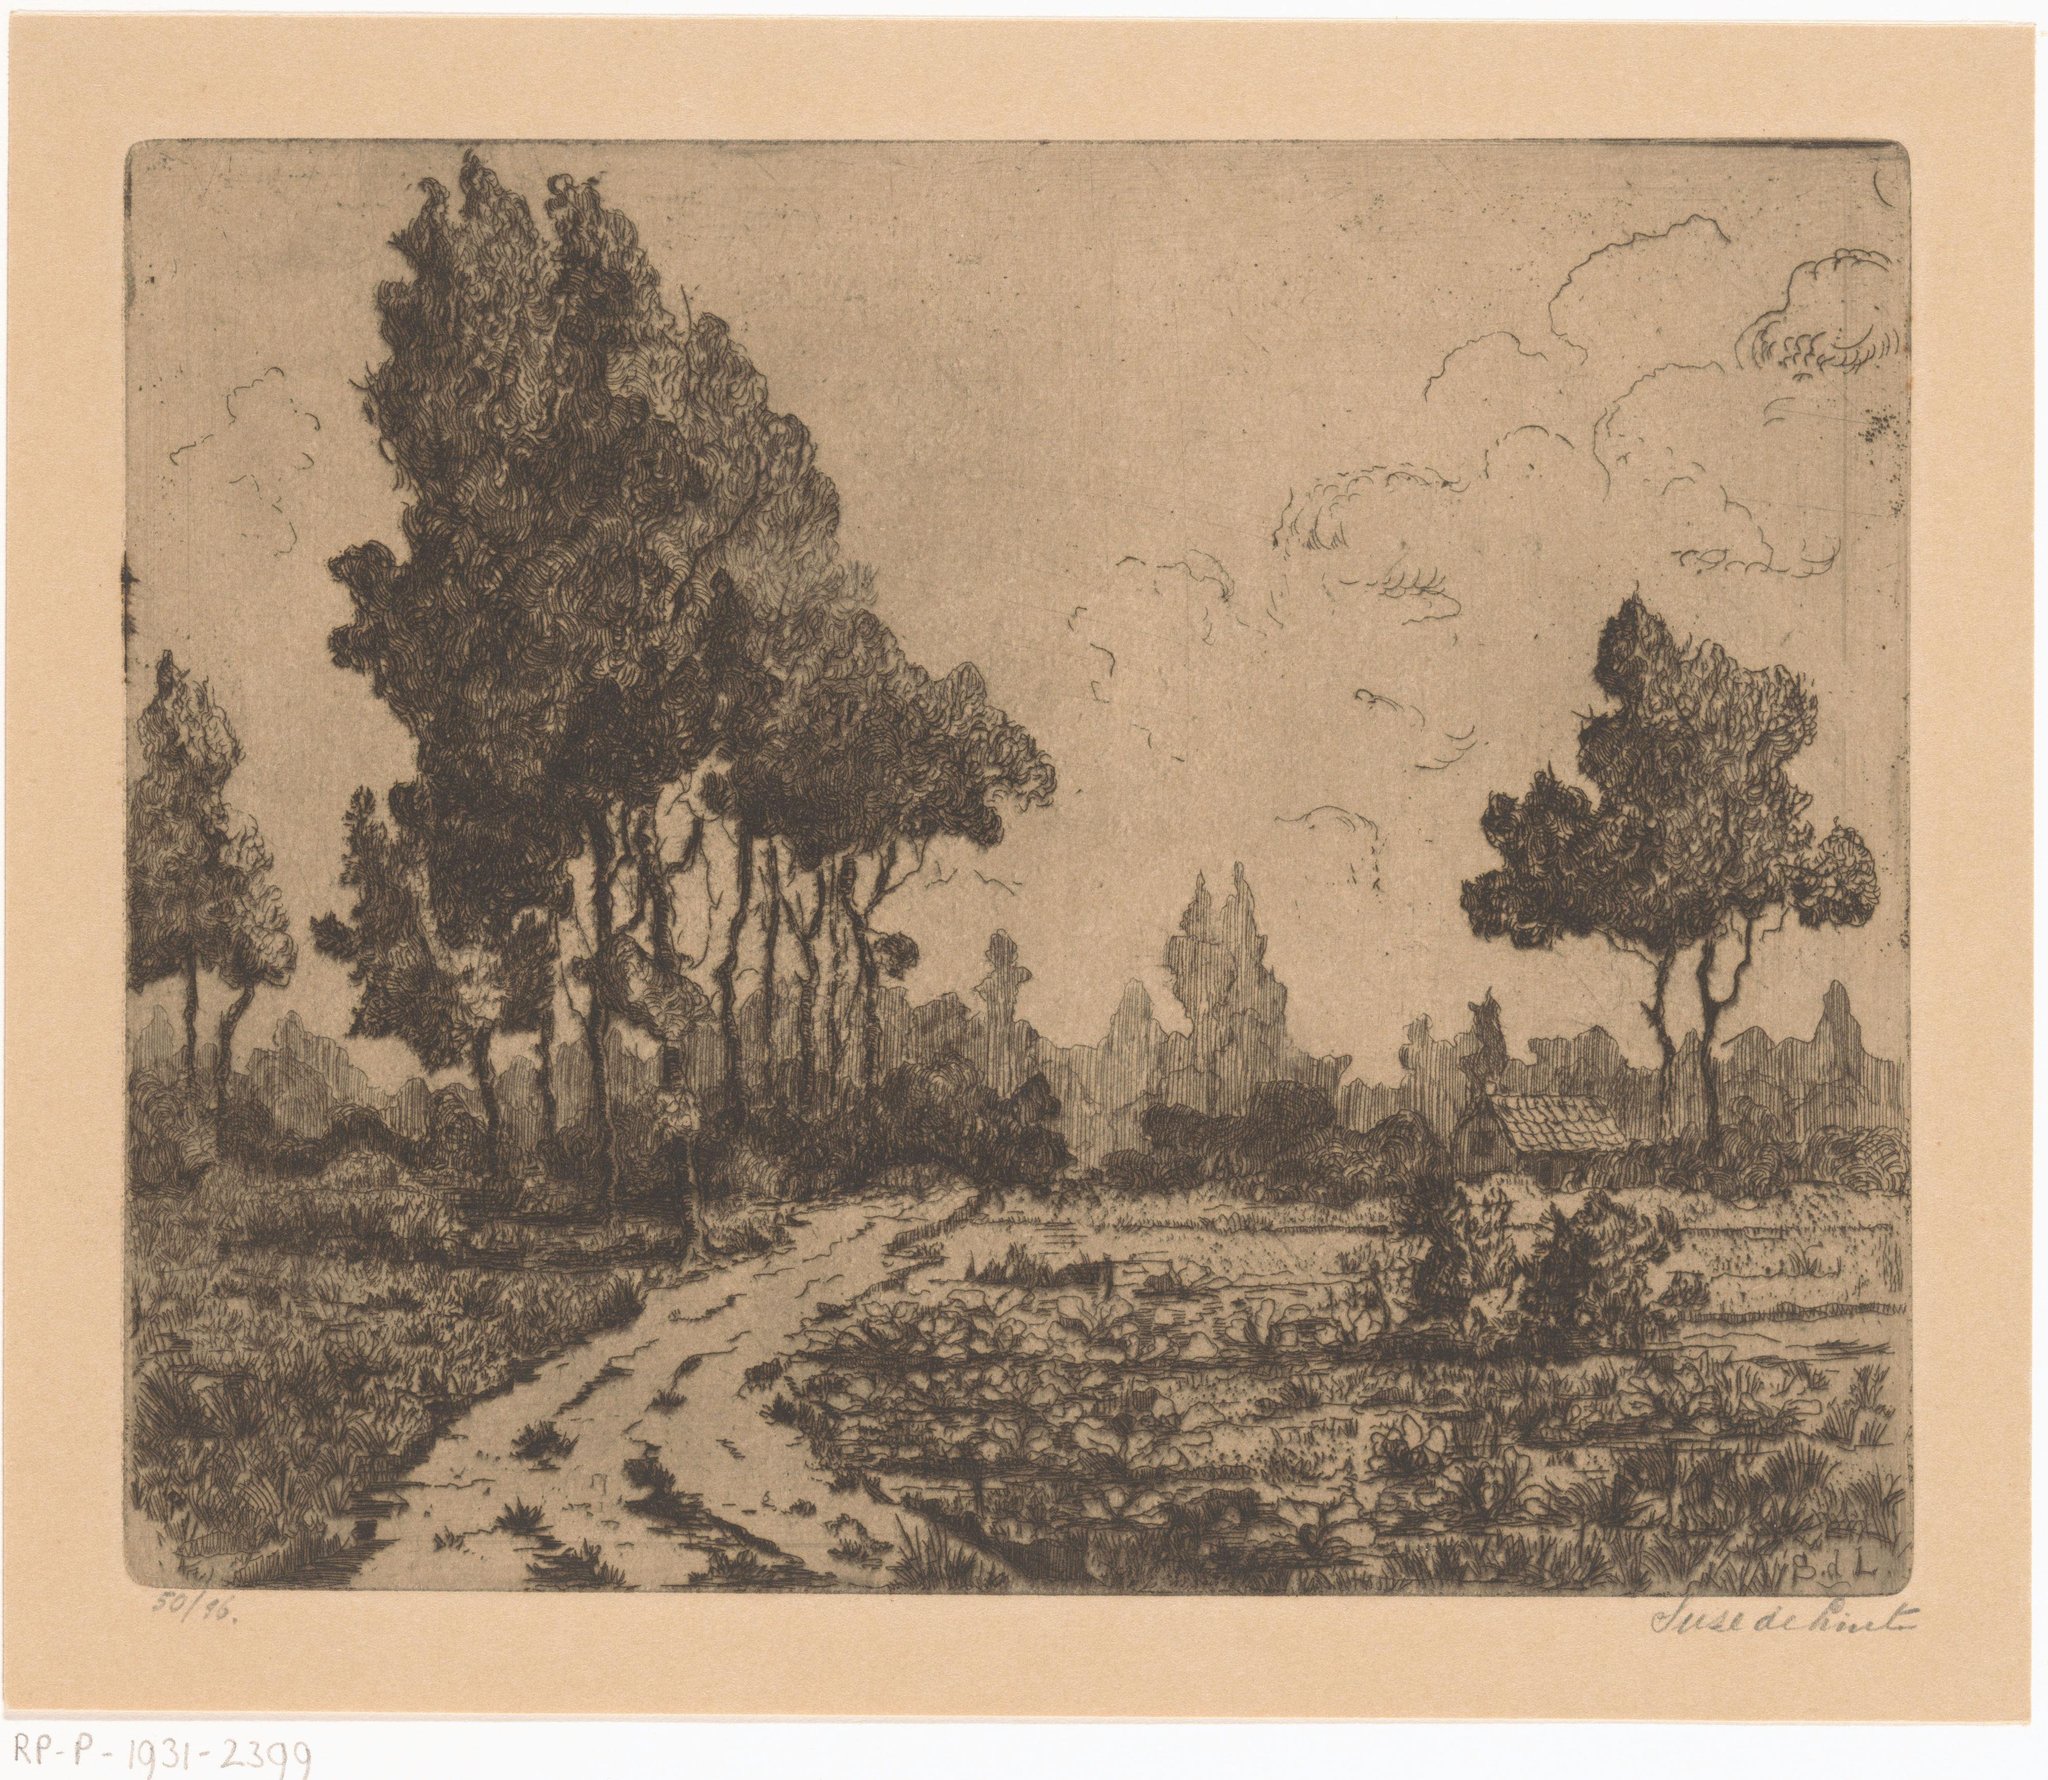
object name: print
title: Landweg langs akkers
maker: suze de lint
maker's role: print maker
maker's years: 1878-1953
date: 1888-1931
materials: paper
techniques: etching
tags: field filled with a crop, road, path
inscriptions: collector's mark: Lugt 2228